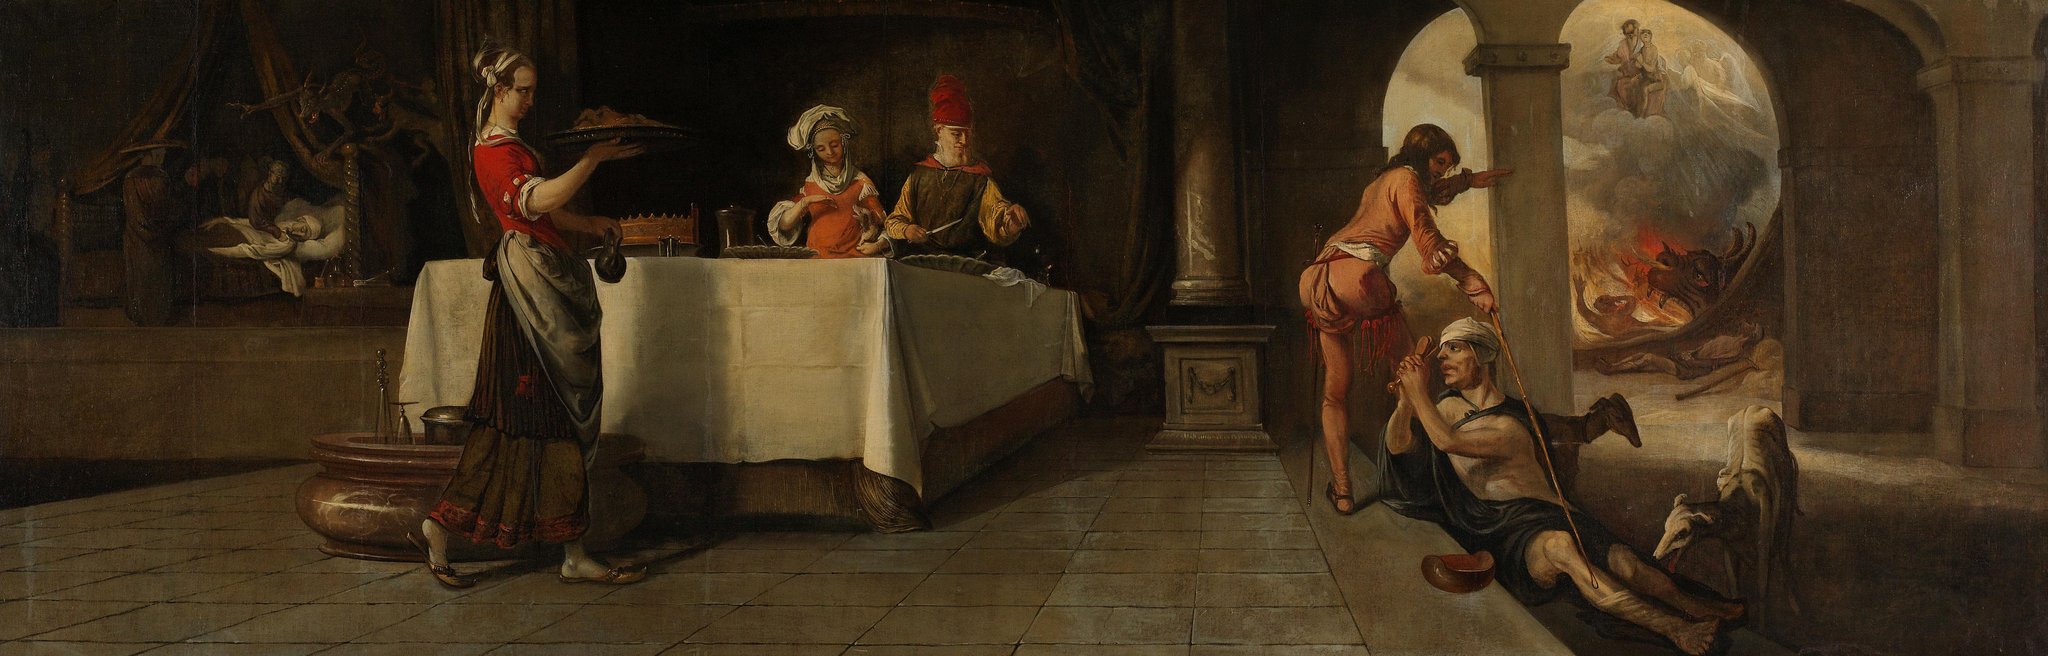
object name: painting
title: Lazarus and the Rich Man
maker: barent fabritius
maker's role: draughtsman, painter, print maker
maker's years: 1624-1673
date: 1661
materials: canvas, oil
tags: the rich man (dives) is feasting, while poor lazarus is starving at the gate (dogs licking lazarus' sores) (luke 16:19-31)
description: De rijke man en de arme Lazarus. De parabel van de rijke man en Lazarus verbeeld in drie taferelen in een interieur. In het midden de rijke man aan een maaltijd, de bedelaar wordt bij de deur verjaagd. Links sterft de rijke man en wordt zijn ziel door duivels gehaald, rechts Lazarus rustend in de schoot van Abraham in de hemel. Het doek maakt deel uit van een reeks van parabels geschilderd voor de Lutherse kerk in Leiden (zie ook nrs. SK-A-2958 en SK-A-2959).